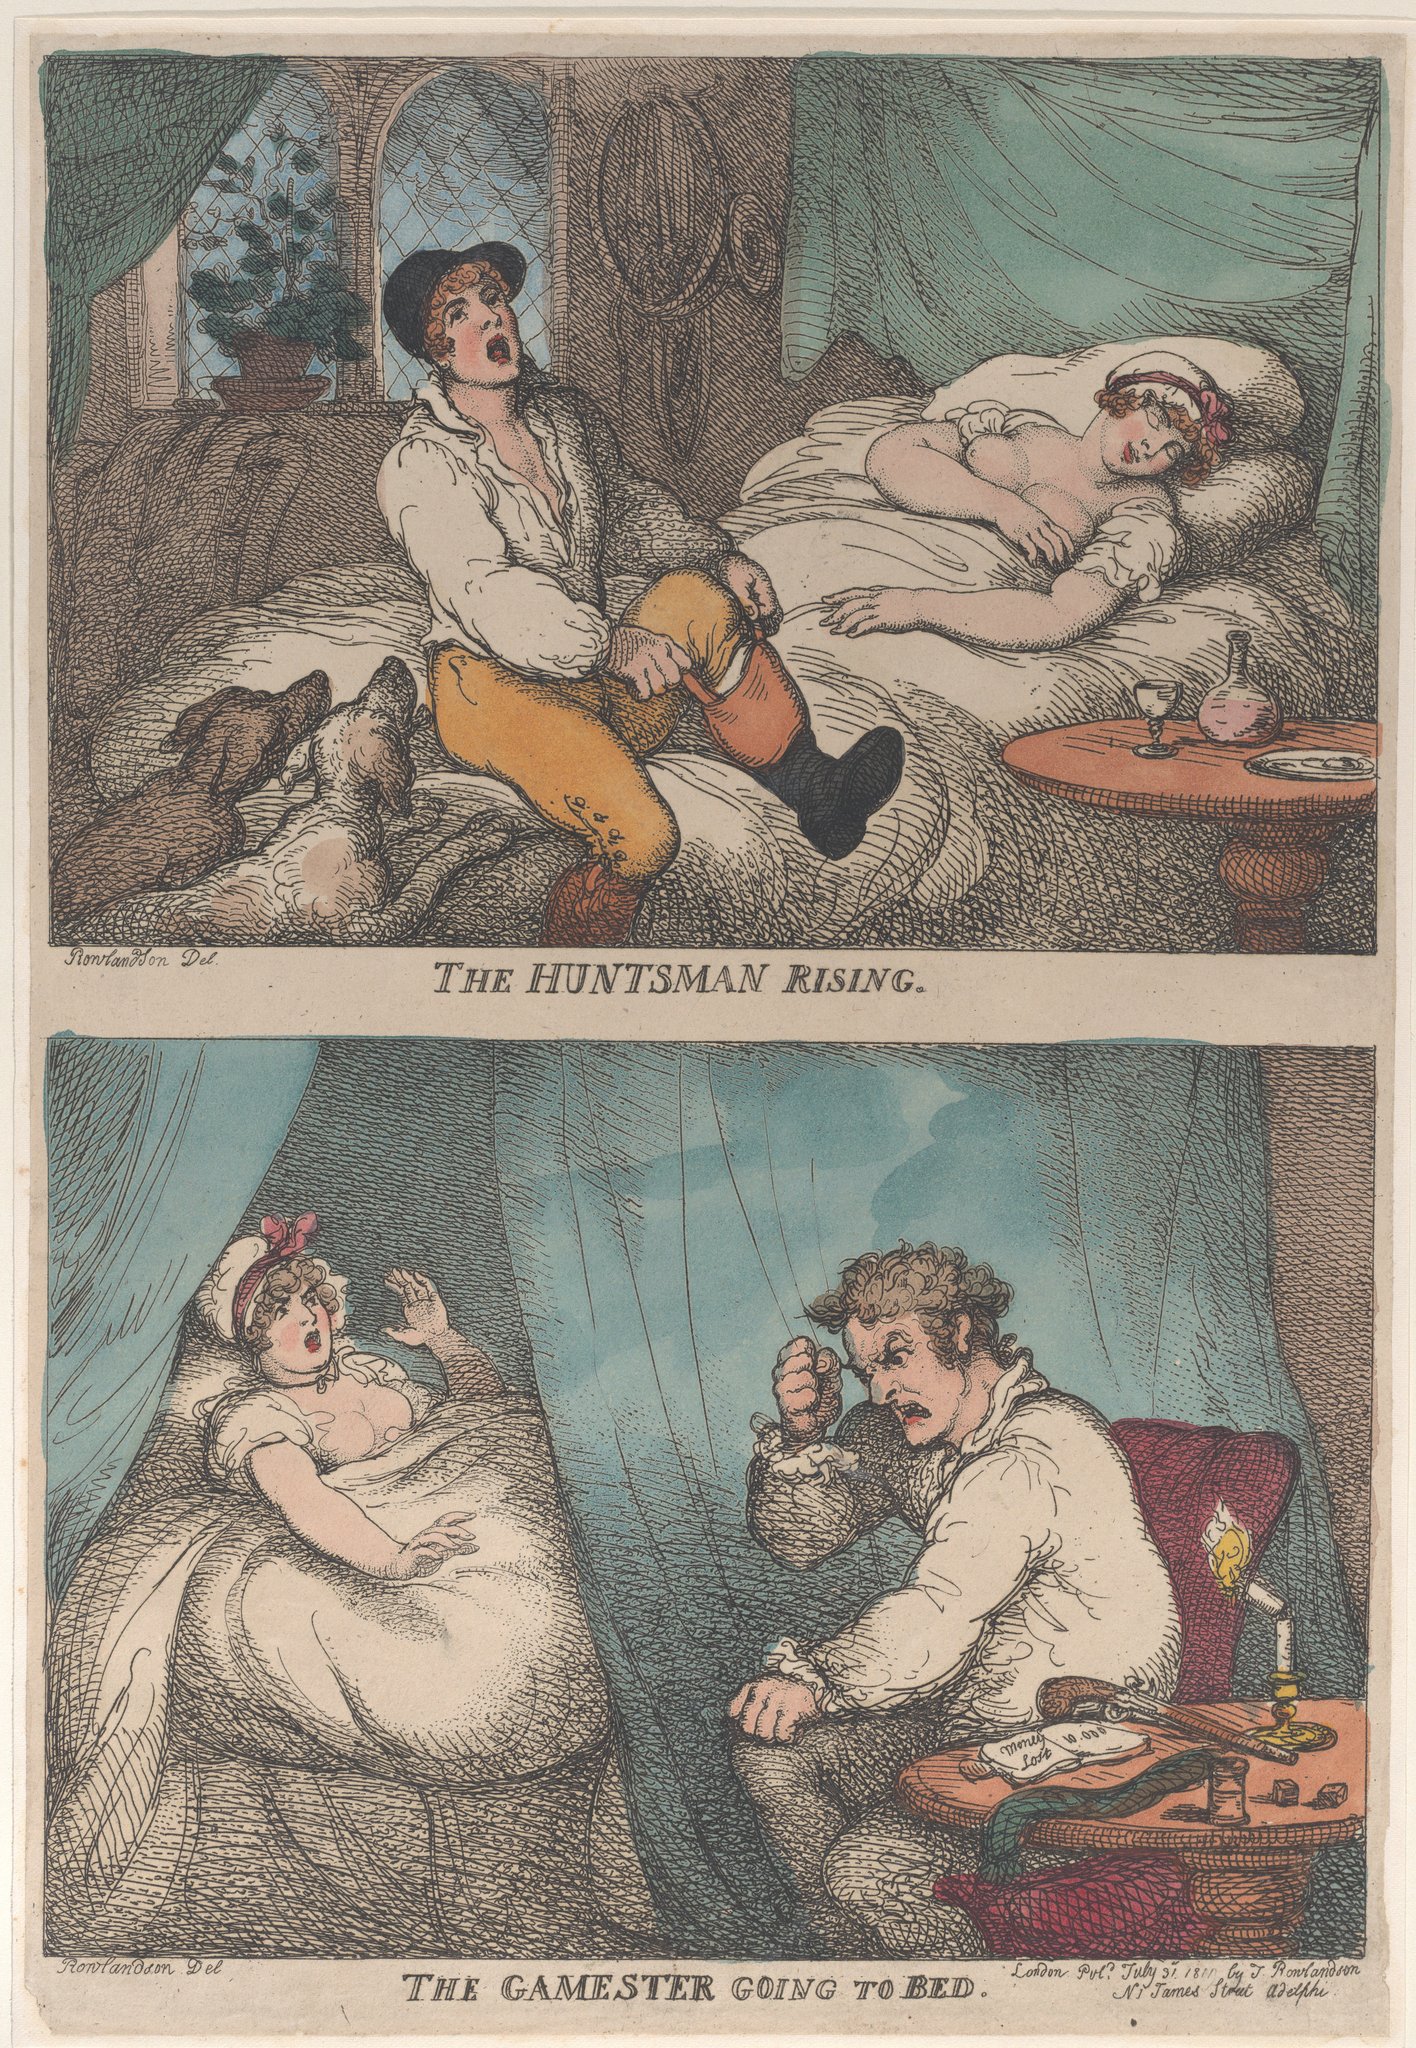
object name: print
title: The Huntsman Rising; The Gamester Going to Bed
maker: thomas rowlandson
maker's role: artist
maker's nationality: british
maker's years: 1757-1827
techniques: etching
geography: london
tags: satire,sleeping,men,women,gambling,dogs